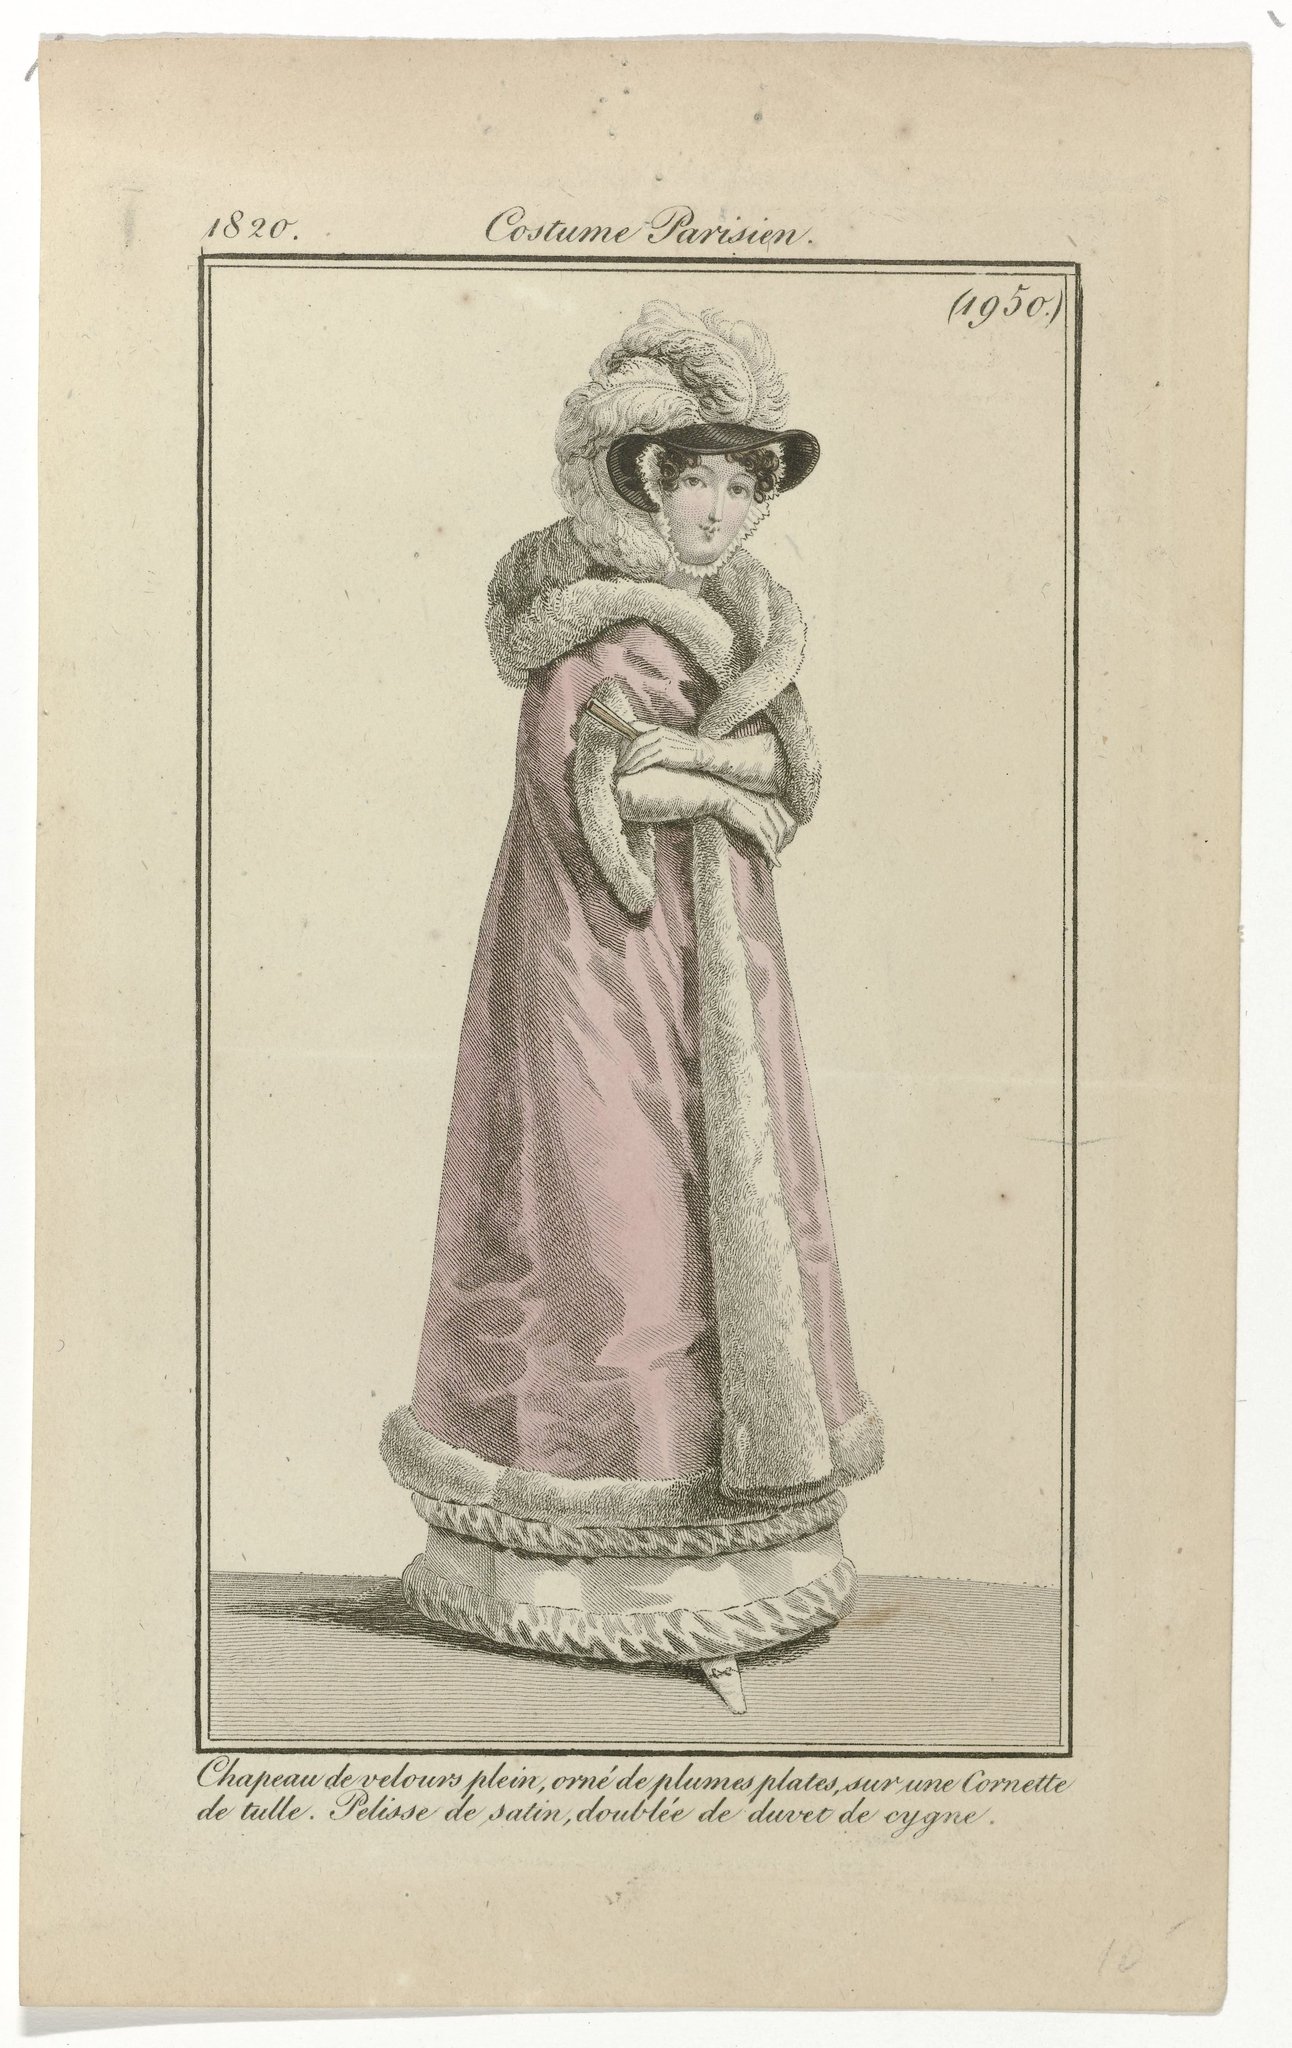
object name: fashion print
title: Journal des Dames et des Modes, Costume Parisien, 20 décembre 1820, (1950): Chapeau de velours plein (...)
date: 1820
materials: paper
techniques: engraving, hand coloring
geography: paris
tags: gloves, mittens (long gloves) (+ women's clothes), head-gear (cornette) (+ women's clothes), cape (pelisse) (+ women's clothes), fashion plates, head-gear: hat (+ women's clothes), shoes, sandals (+ women's clothes), skirt (+ women's clothes), fan (+ women's clothes)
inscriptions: title: ‘Costume Parisien.’, caption: ‘Chapeau de velours plein, orné de plumes plates, sur une Cornette de tulle. pelisse de satin, doublée de duvet de cygne.’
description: Vrouw gekleed in een 'pelisse' van satijn, gevoerd met zwanendons. Op het hoofd een hoed van effen fluweel versierd met veren, op een 'cornette' van tule. Verdere accessoires: lange handschoenen, waaier, schoen met strik. De prent maakt deel uit van het modetijdschrift Journal des Dames et des Modes, uitgegeven door Pierre de la Mésangère, Parijs, 1797-1839.